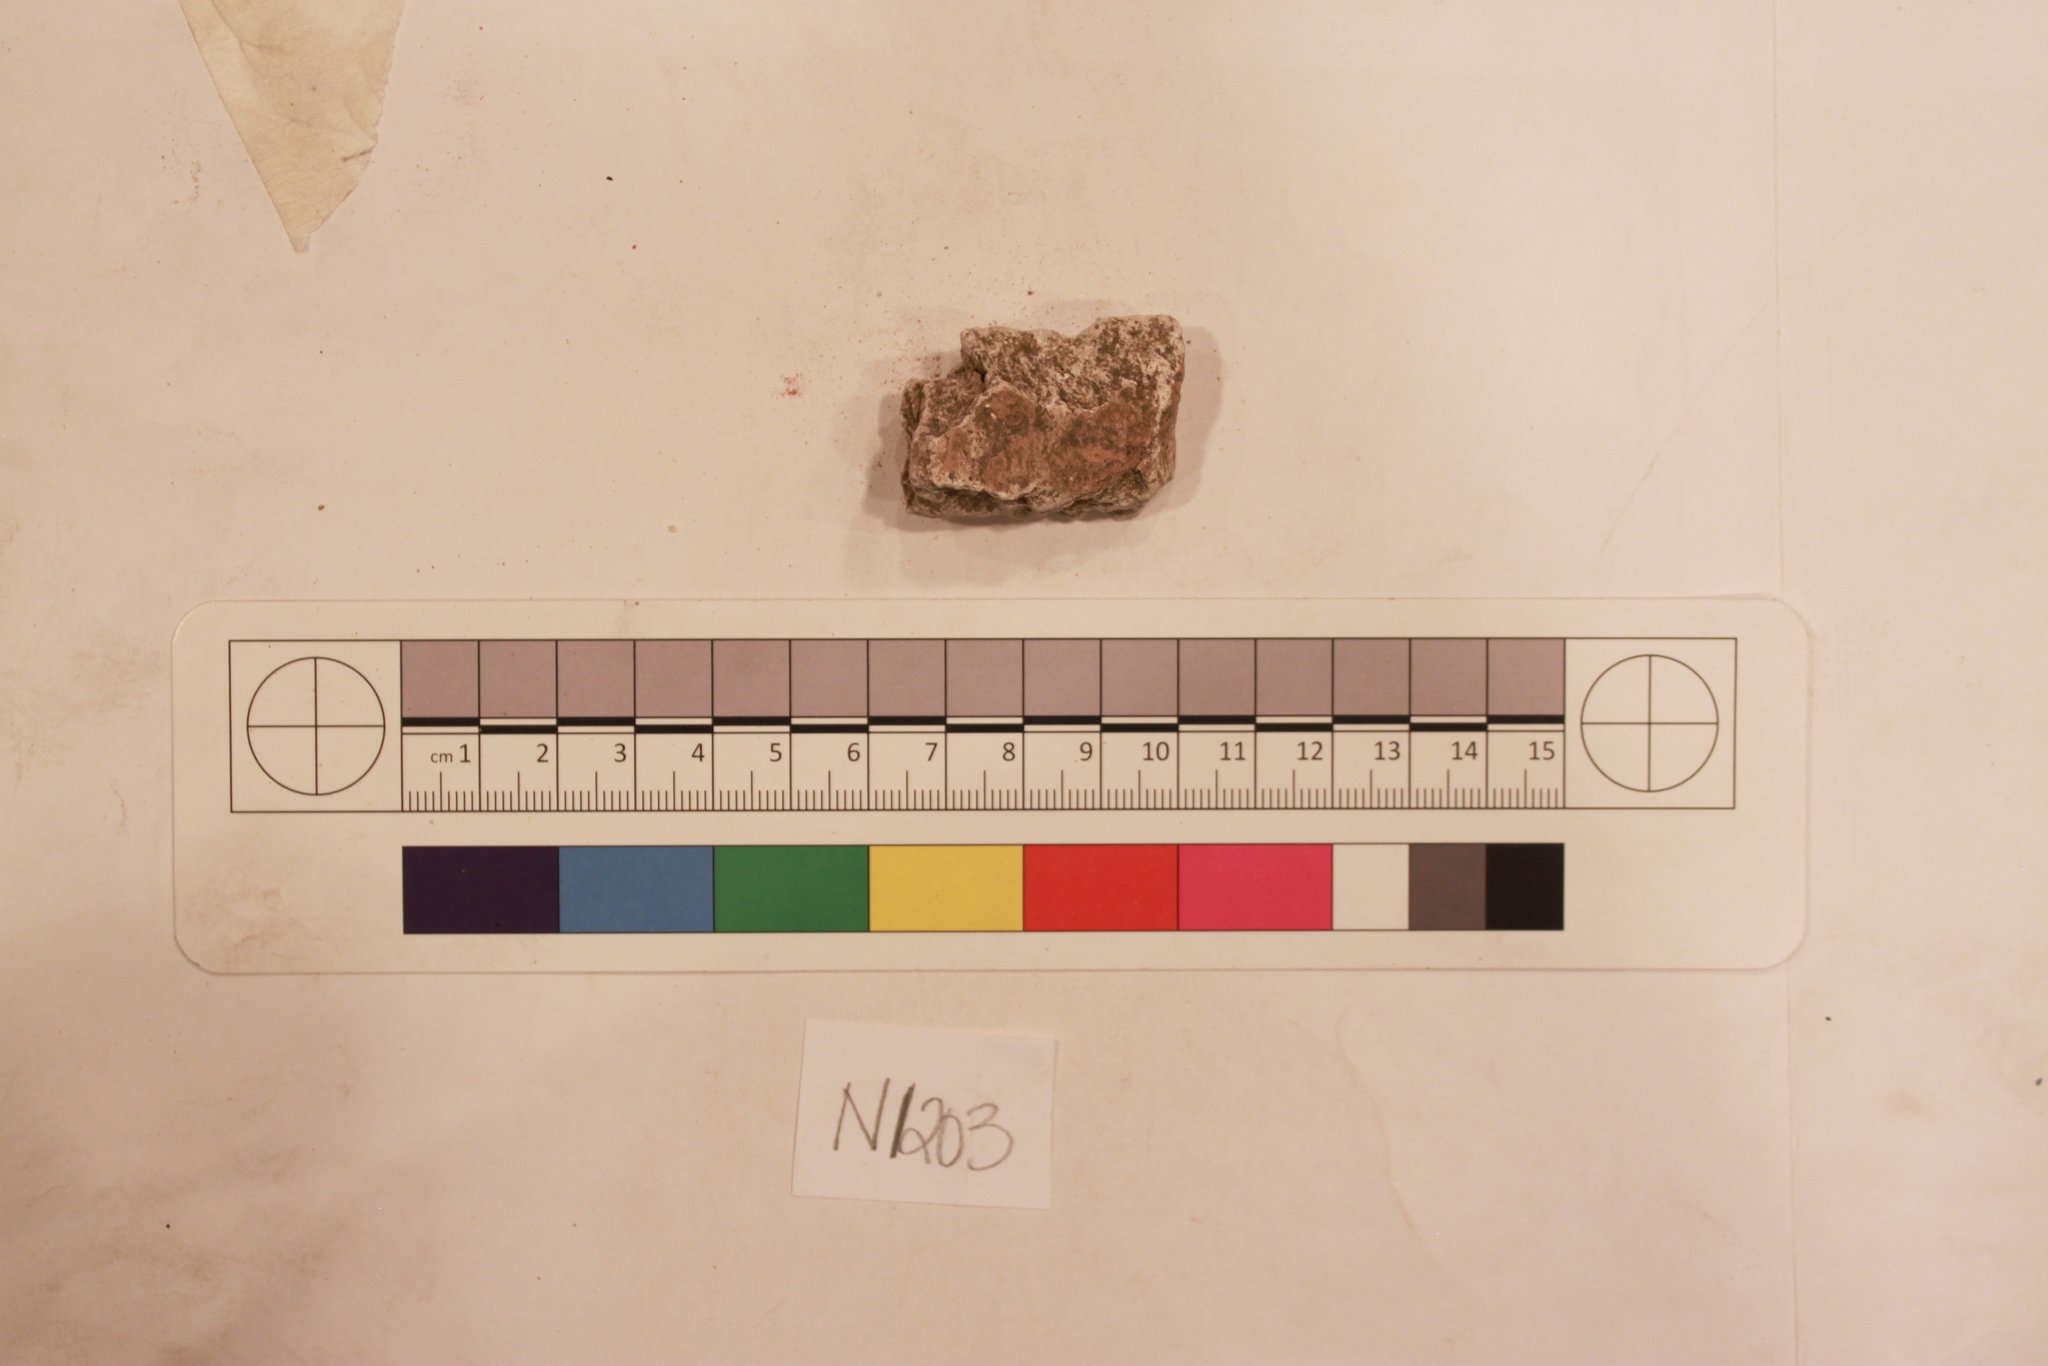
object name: fragment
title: Stucco Fragment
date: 701-1200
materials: plaster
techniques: carving, painting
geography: iran